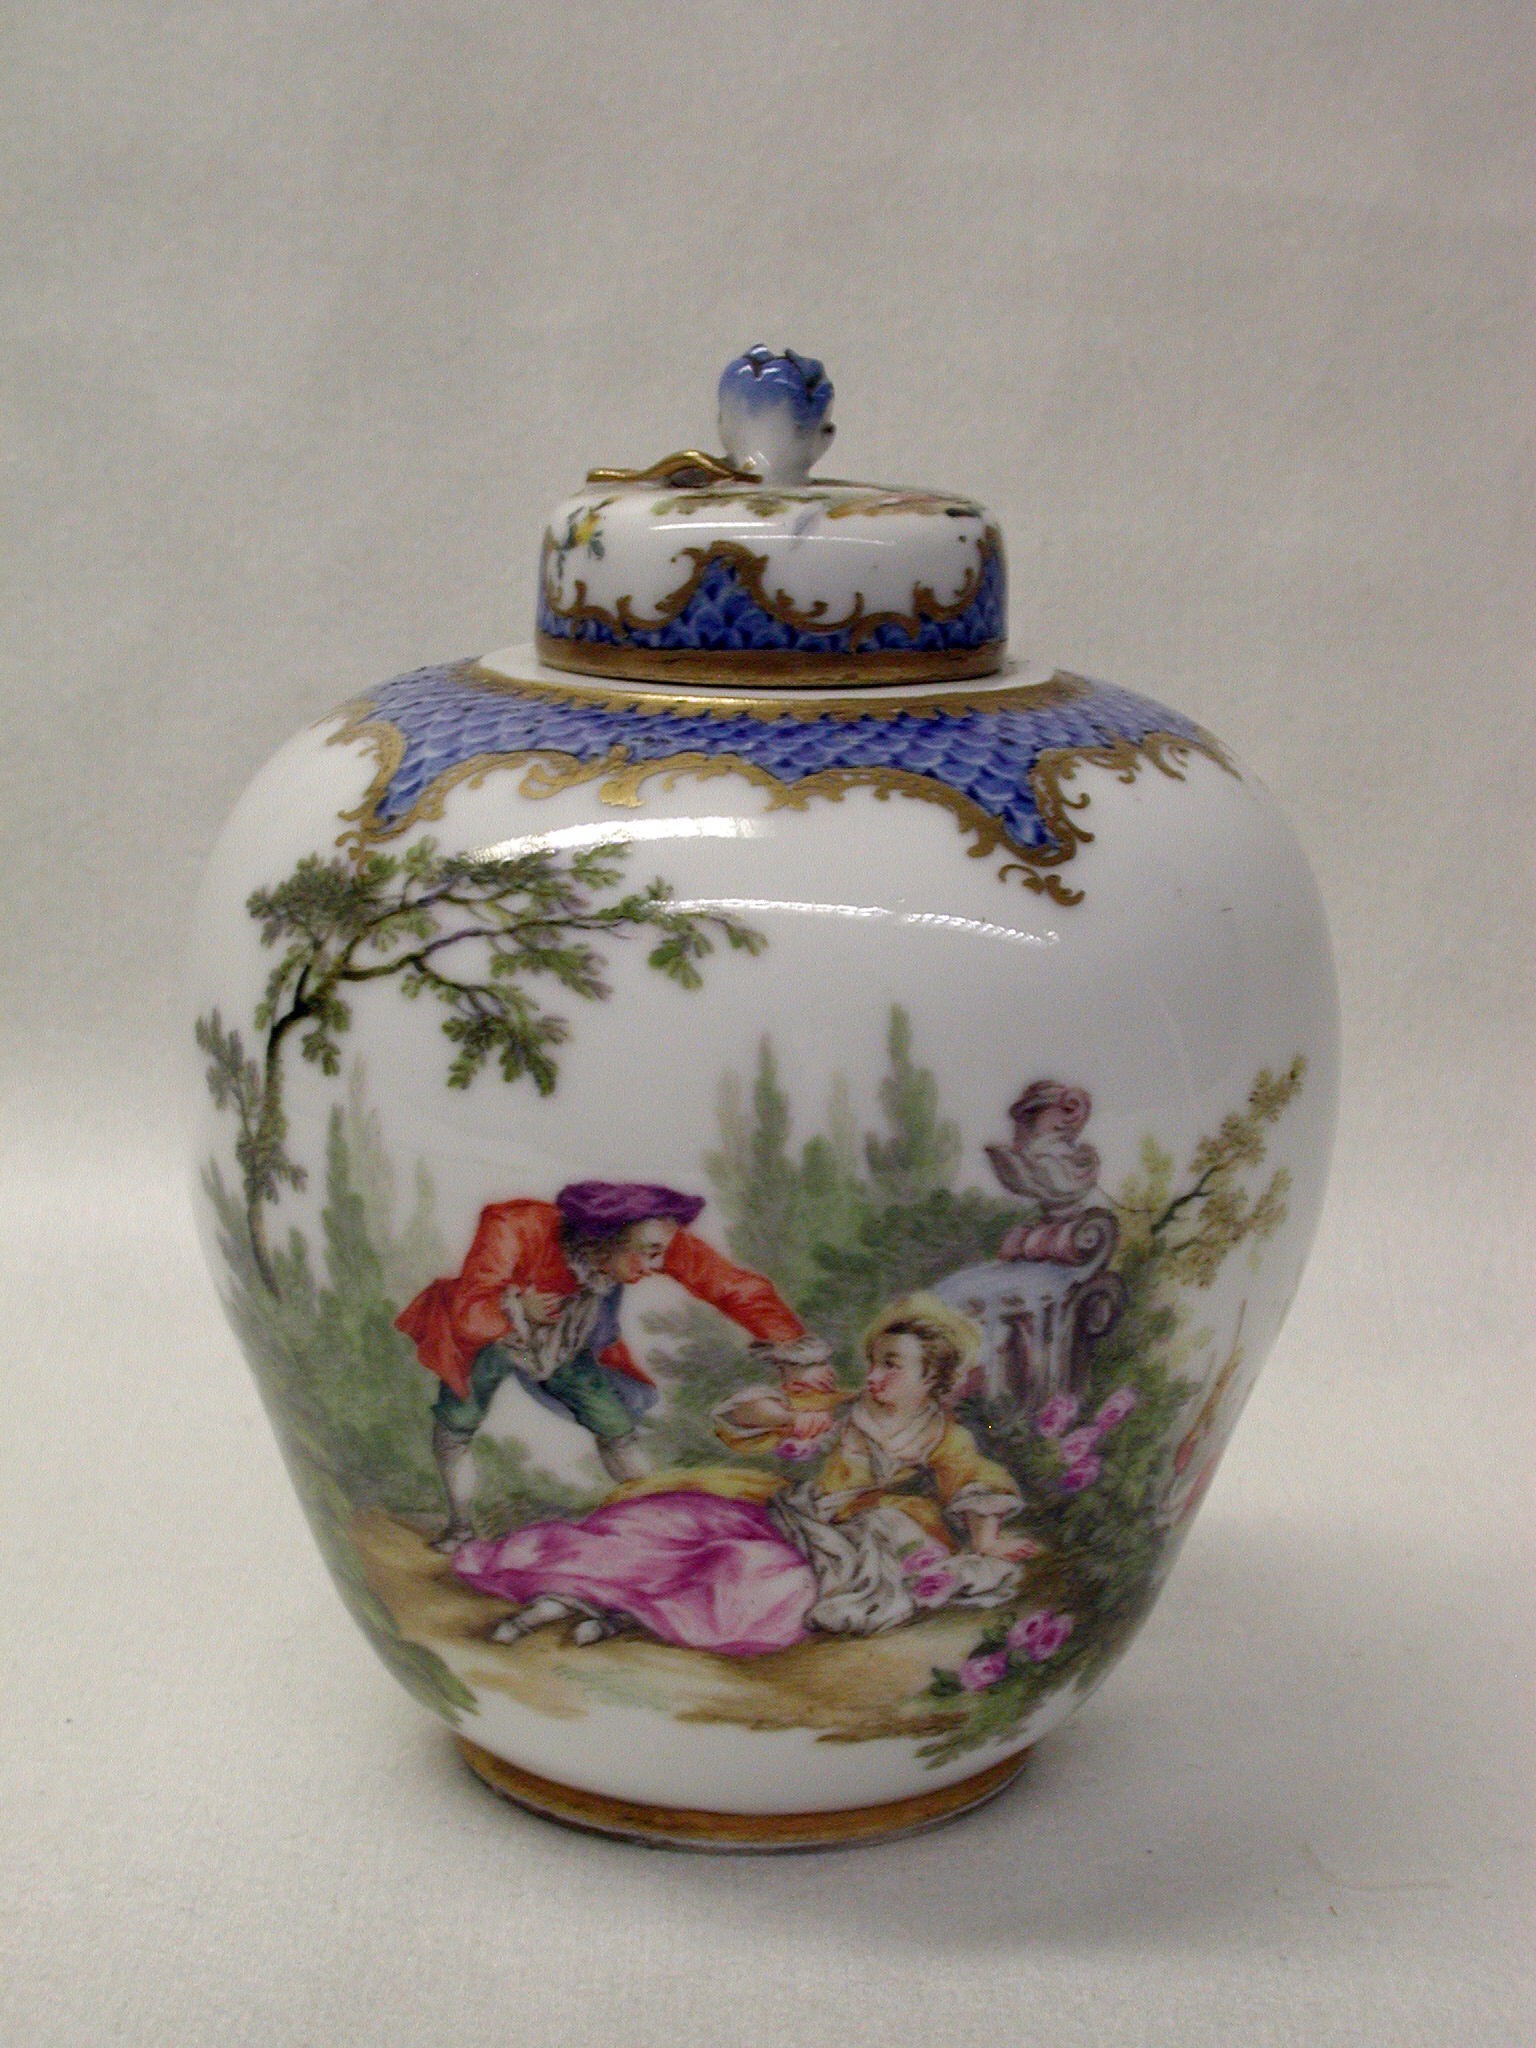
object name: tea caddy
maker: meissen manufactory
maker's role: manufactory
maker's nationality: german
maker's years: 1710-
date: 1801-1900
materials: hard paste porcelain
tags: men,women